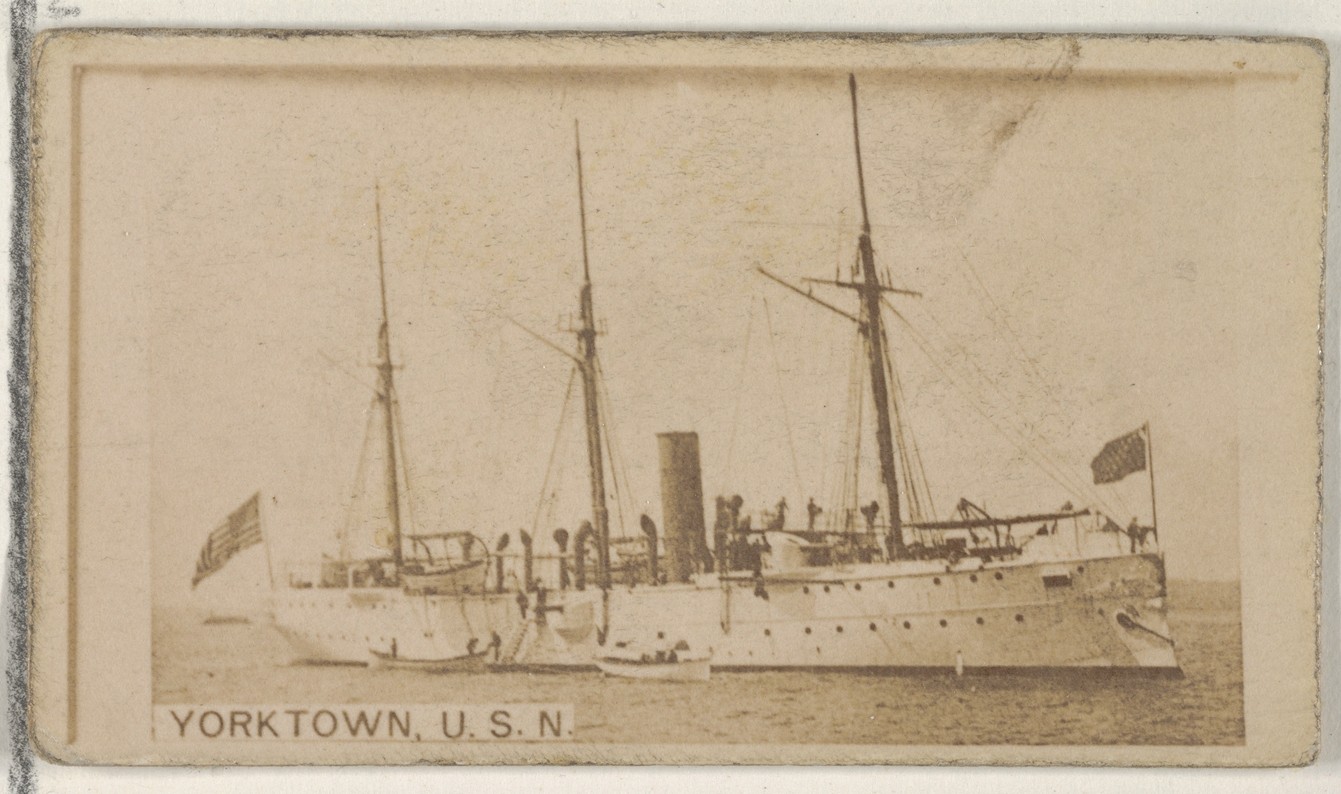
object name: photograph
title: Yorktown, U.S.N., from the Famous Ships series (N50) for Virginia Brights Cigarettes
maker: allen & ginter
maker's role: publisher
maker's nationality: american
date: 1895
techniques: albumen silver print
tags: ships